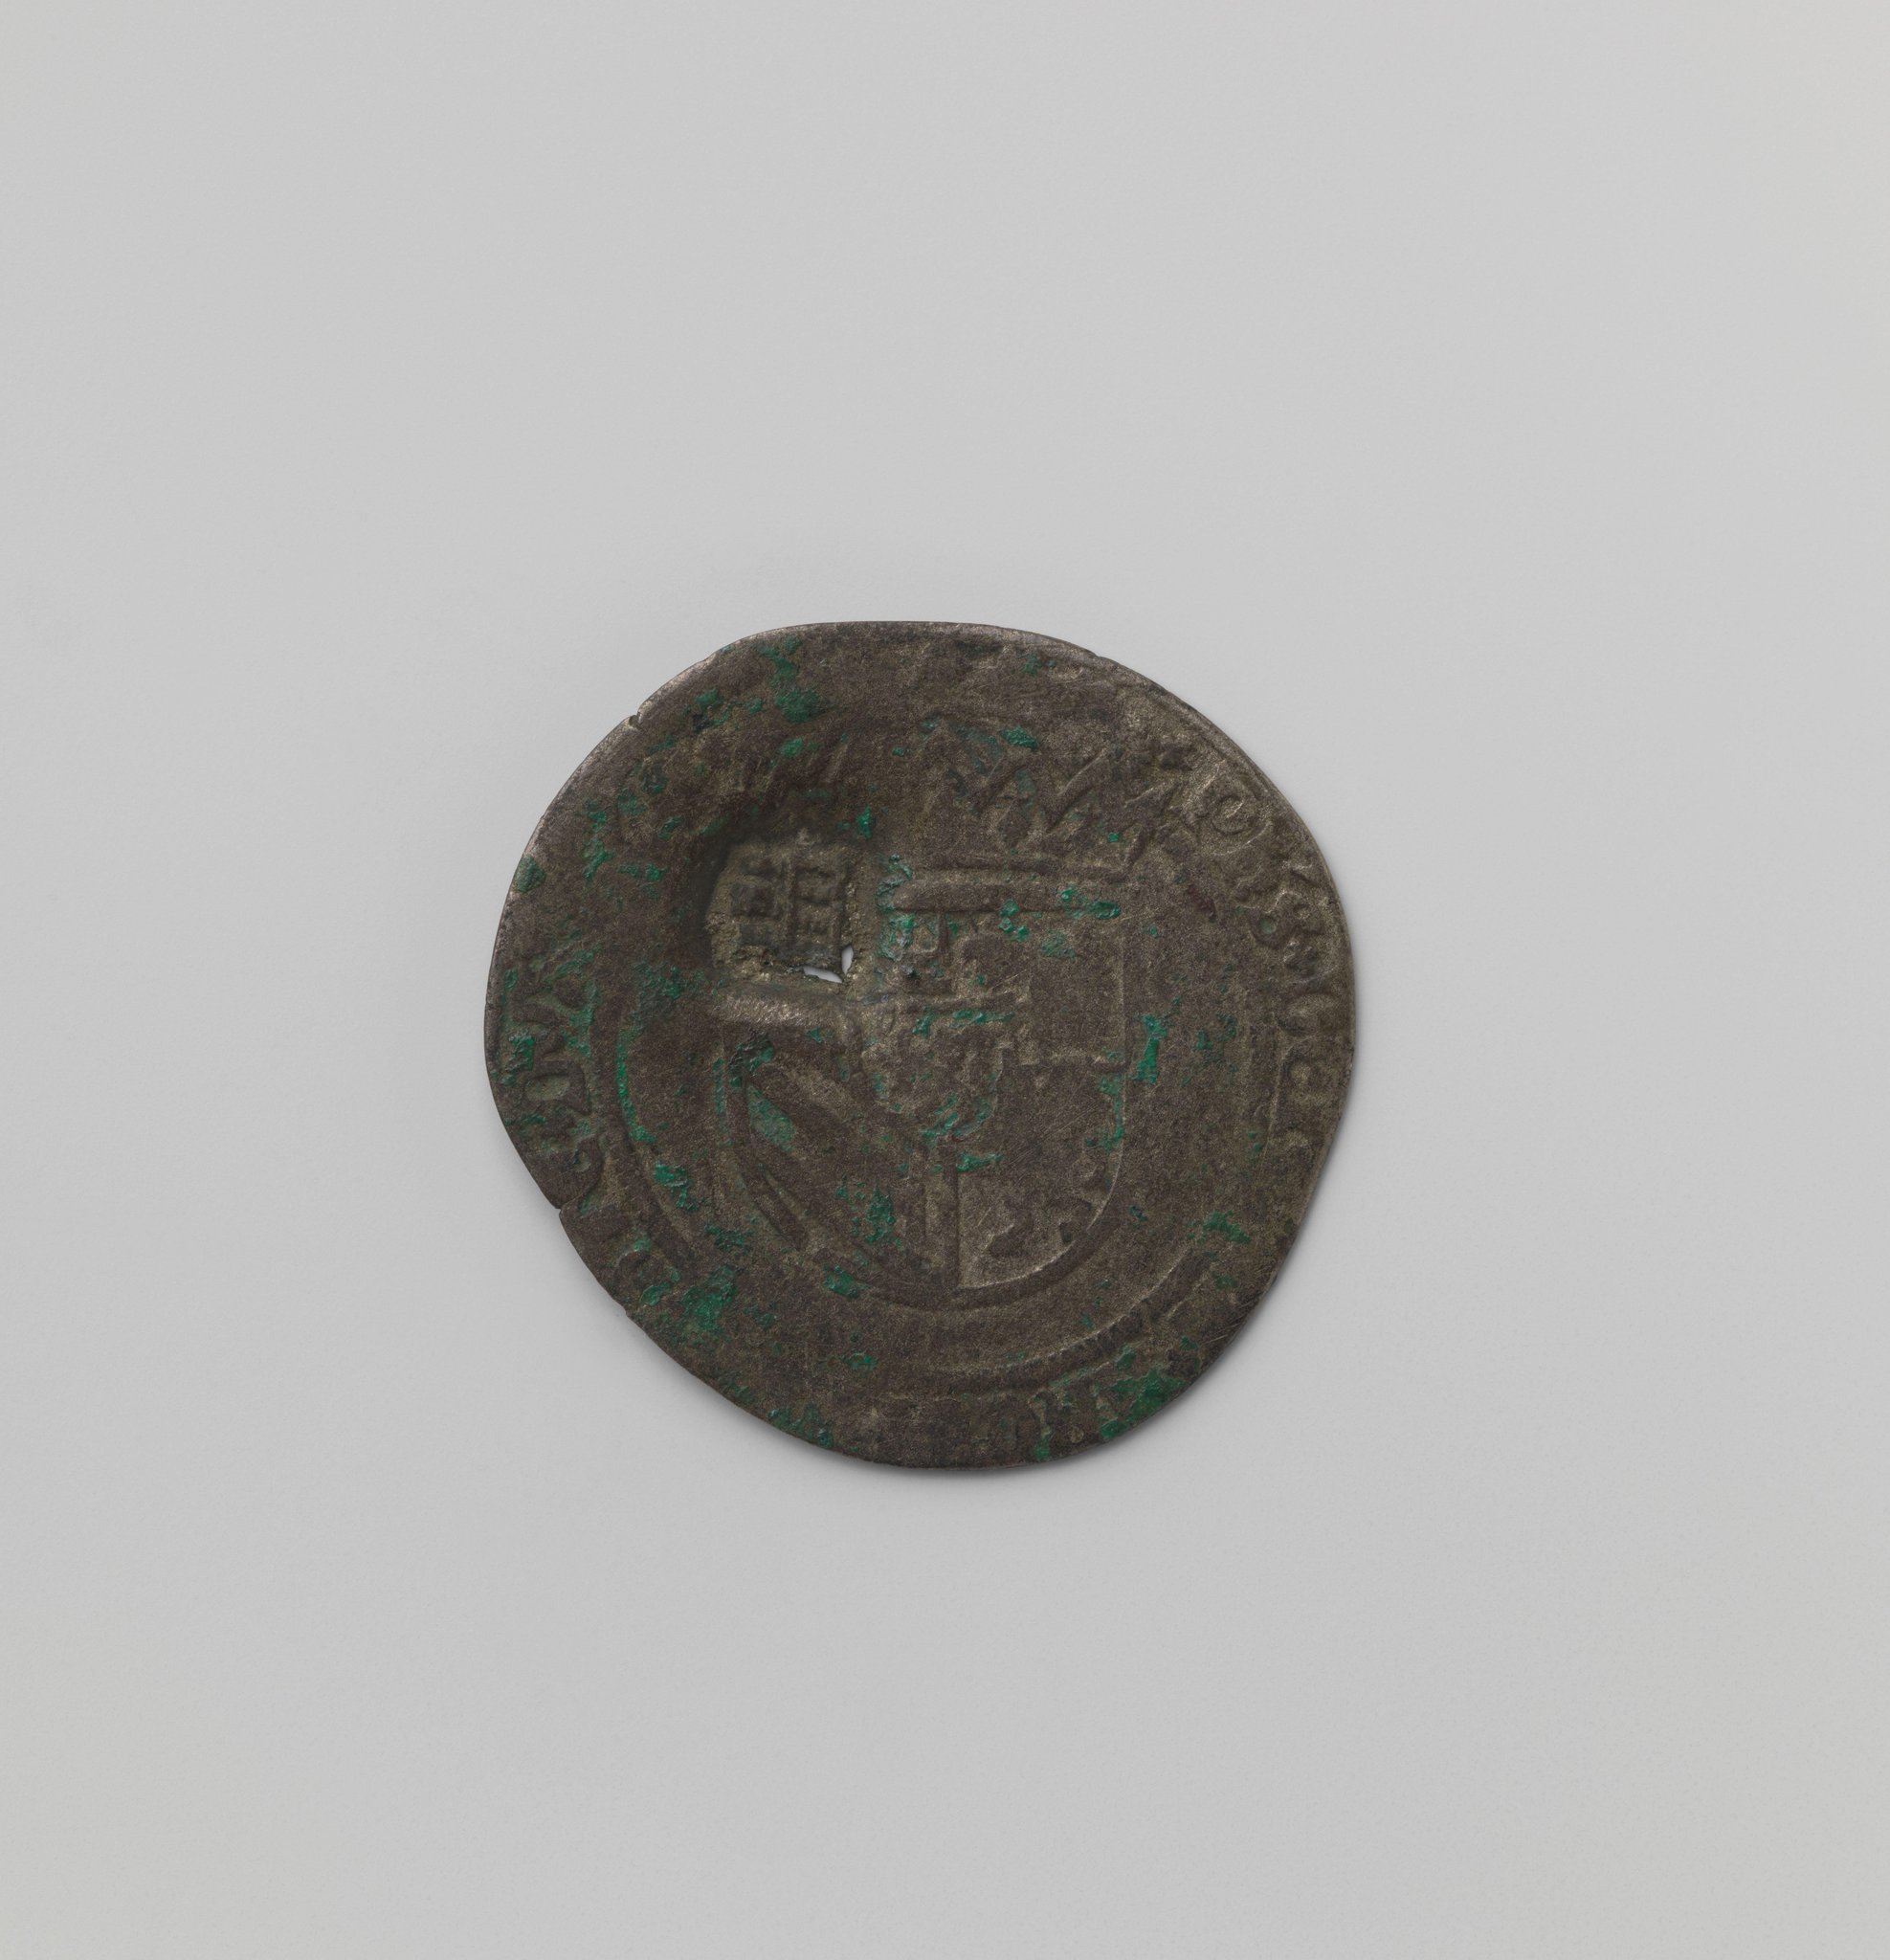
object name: coin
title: Stuiver uit Brabant van Philips de Schone, 1482-1506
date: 1496-1499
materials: silver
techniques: striking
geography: antwerp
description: Zilveren munt. Voorzijde: gekroond samengesteld wapenschild van Bourgondië. Kroon doorbreekt omschrift. Keerzijde: op een vierpas lang gebloemd kruis, in het hart een leeuw. Op voorzijde klop.